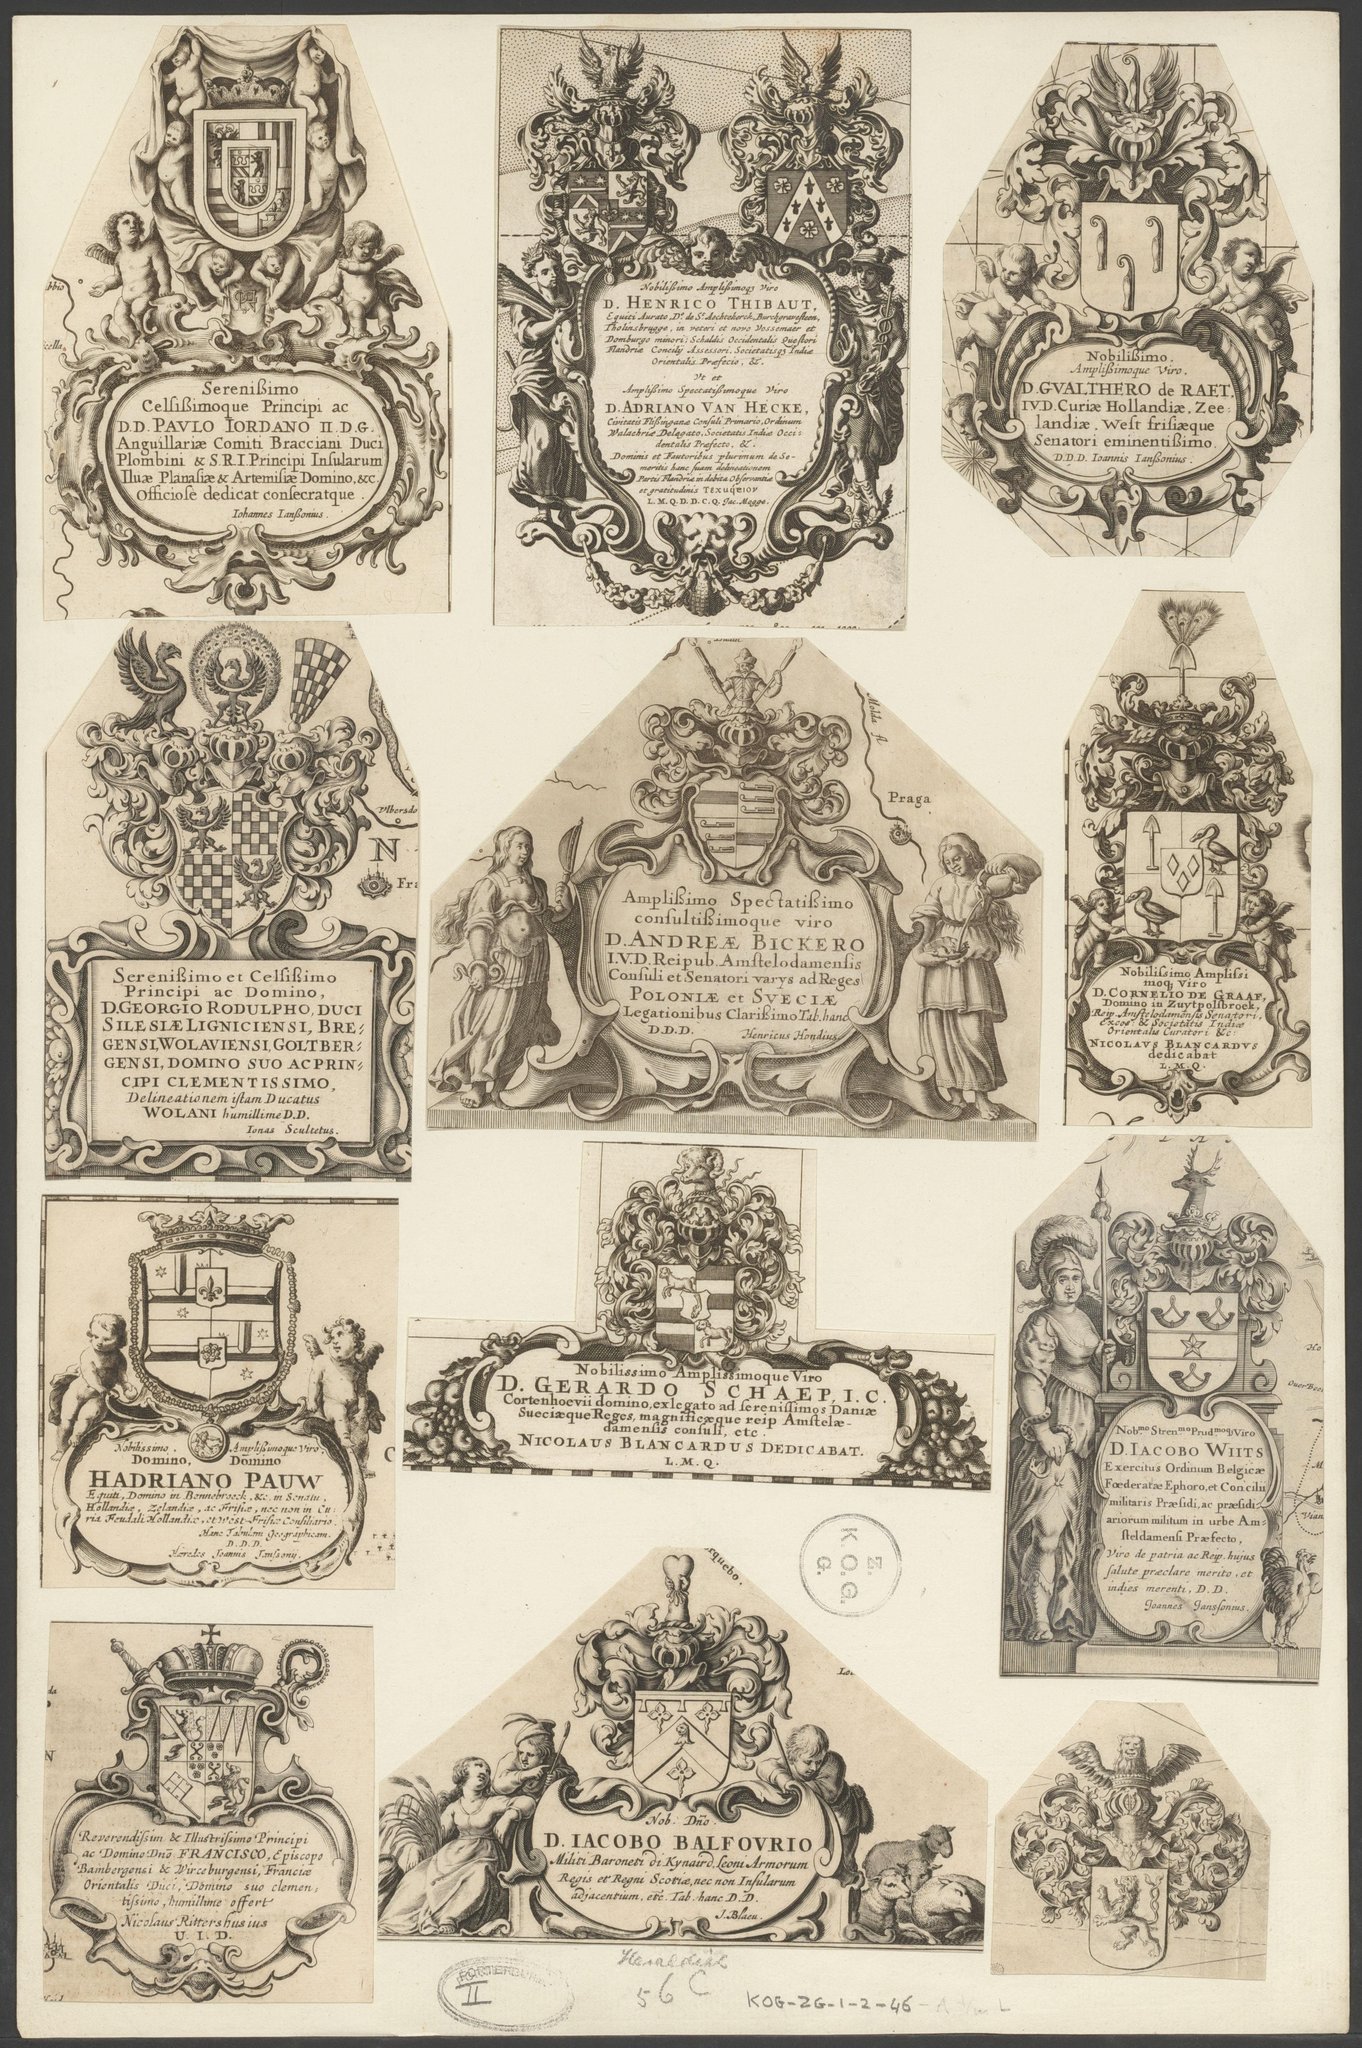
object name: print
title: Blad met 12 diverse wapens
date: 1600-1699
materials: paper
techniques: engraving, etching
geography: amsterdam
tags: armorial bearing, heraldry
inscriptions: collector's mark, collector's mark: Lugt 1641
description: Blad met 12 diverse familiewapens, merendeels met de opdrachten door de uitgever Janssonius. Stukken papier in verschillende formaten, sommige met gedrukte tekst op verso, uitgeknipt en opgeplakt, Onderwerpsrubrieken binnen de Atlas Zeden en Gewoonten: Regeering, Wapens (Heraldiek), Geslachtswapens.